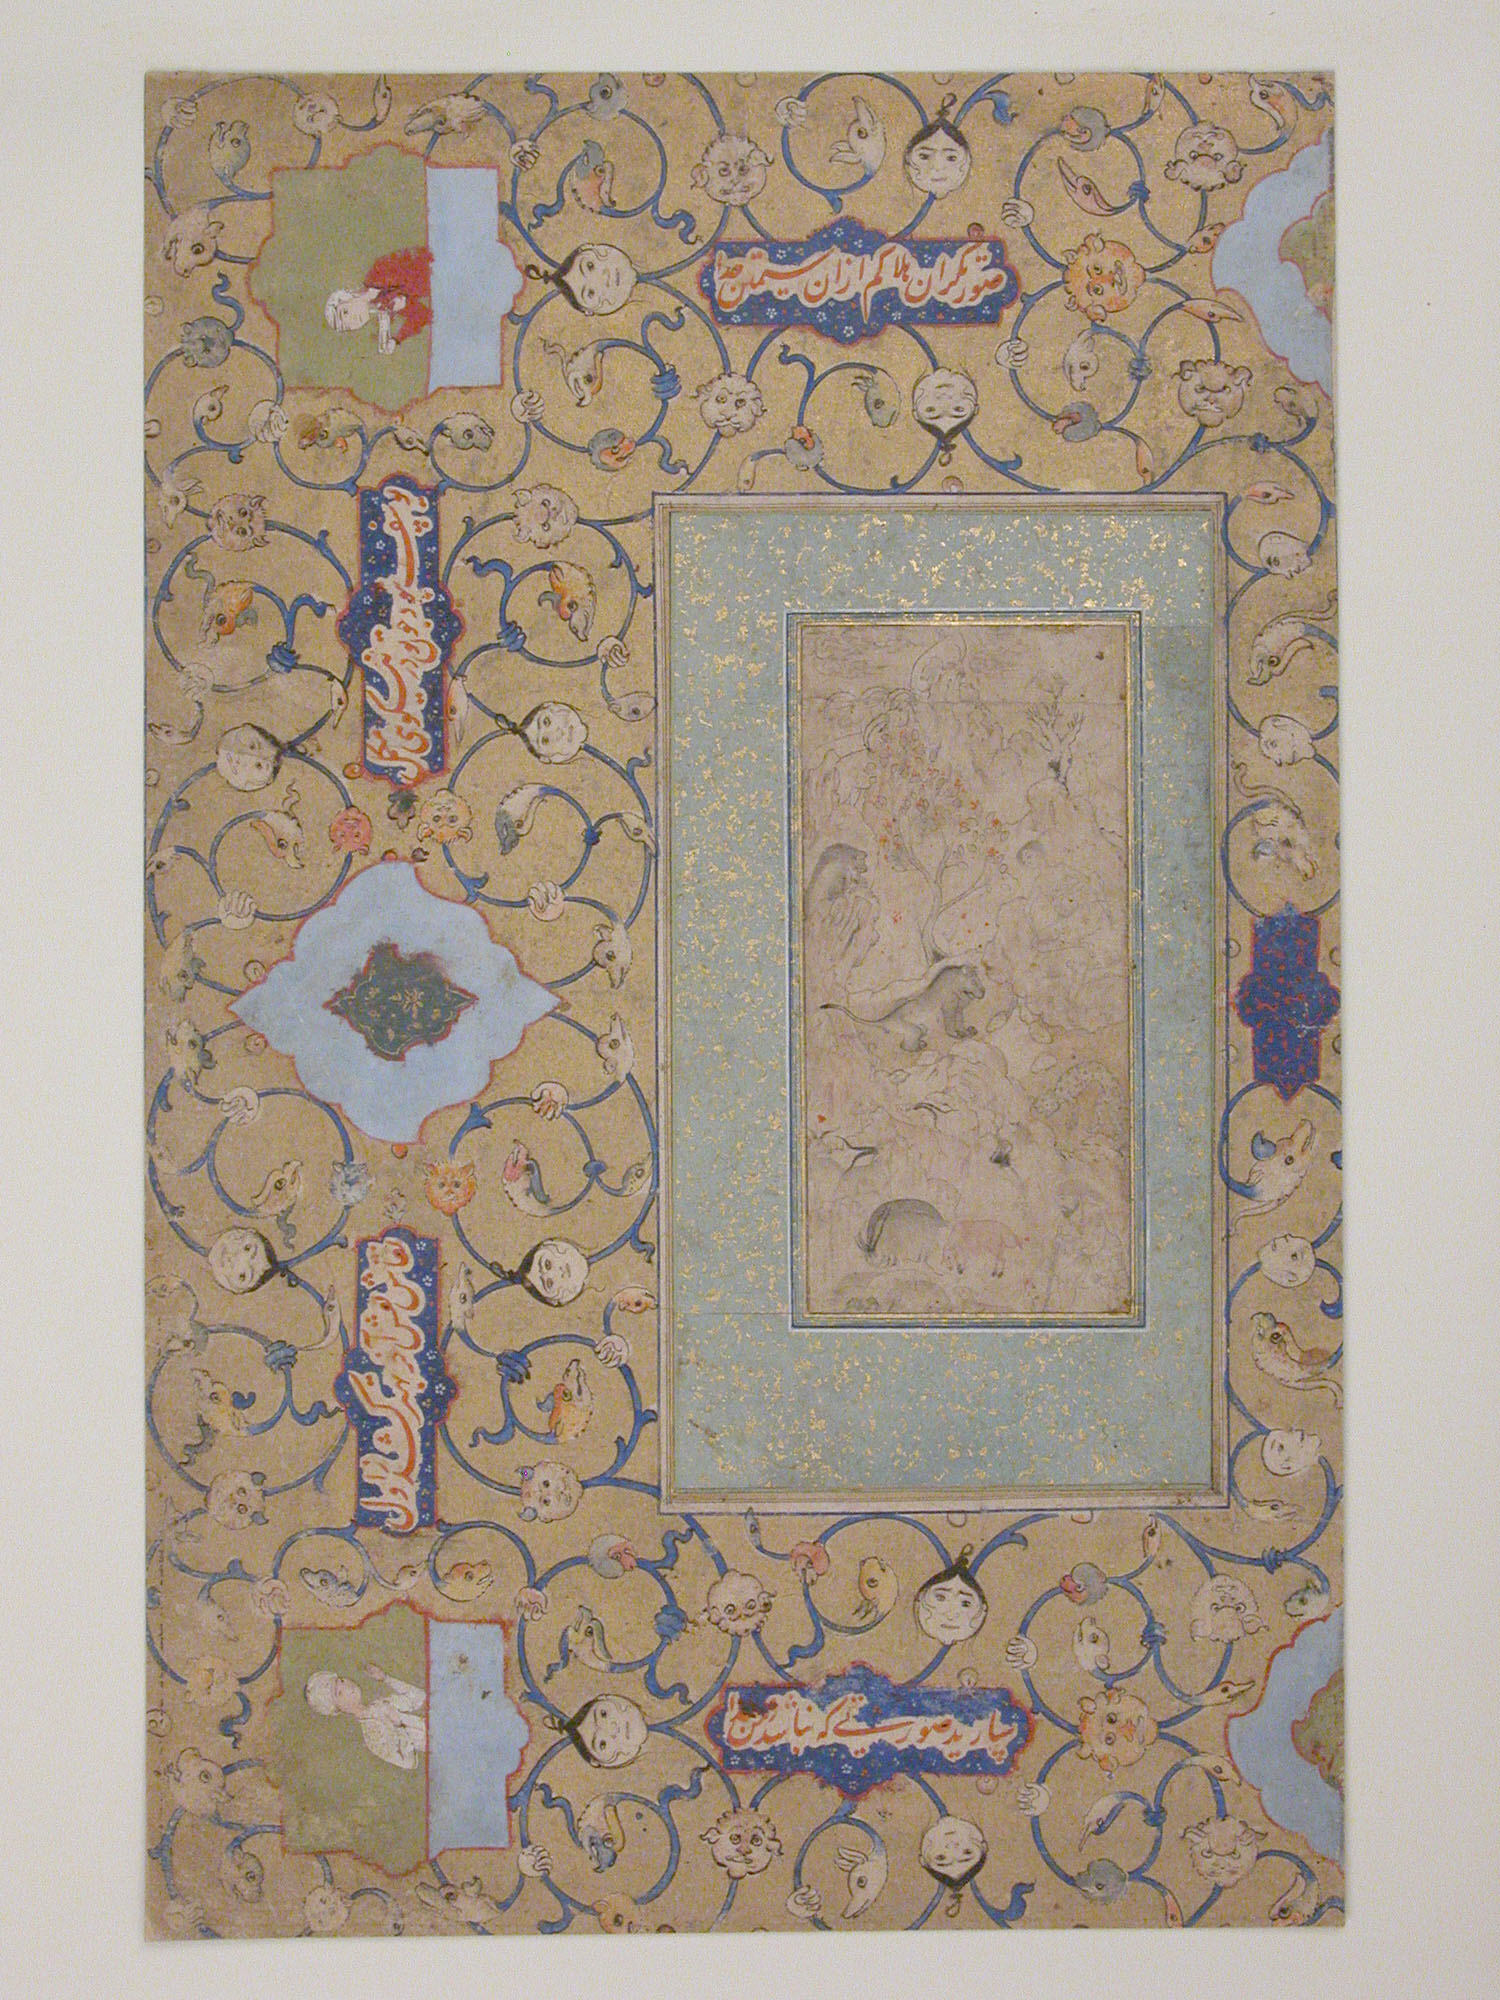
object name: illustrated album leaf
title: Majnun in the Wilderness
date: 1576-1600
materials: ink, paper, watercolor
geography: iran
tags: animals,men